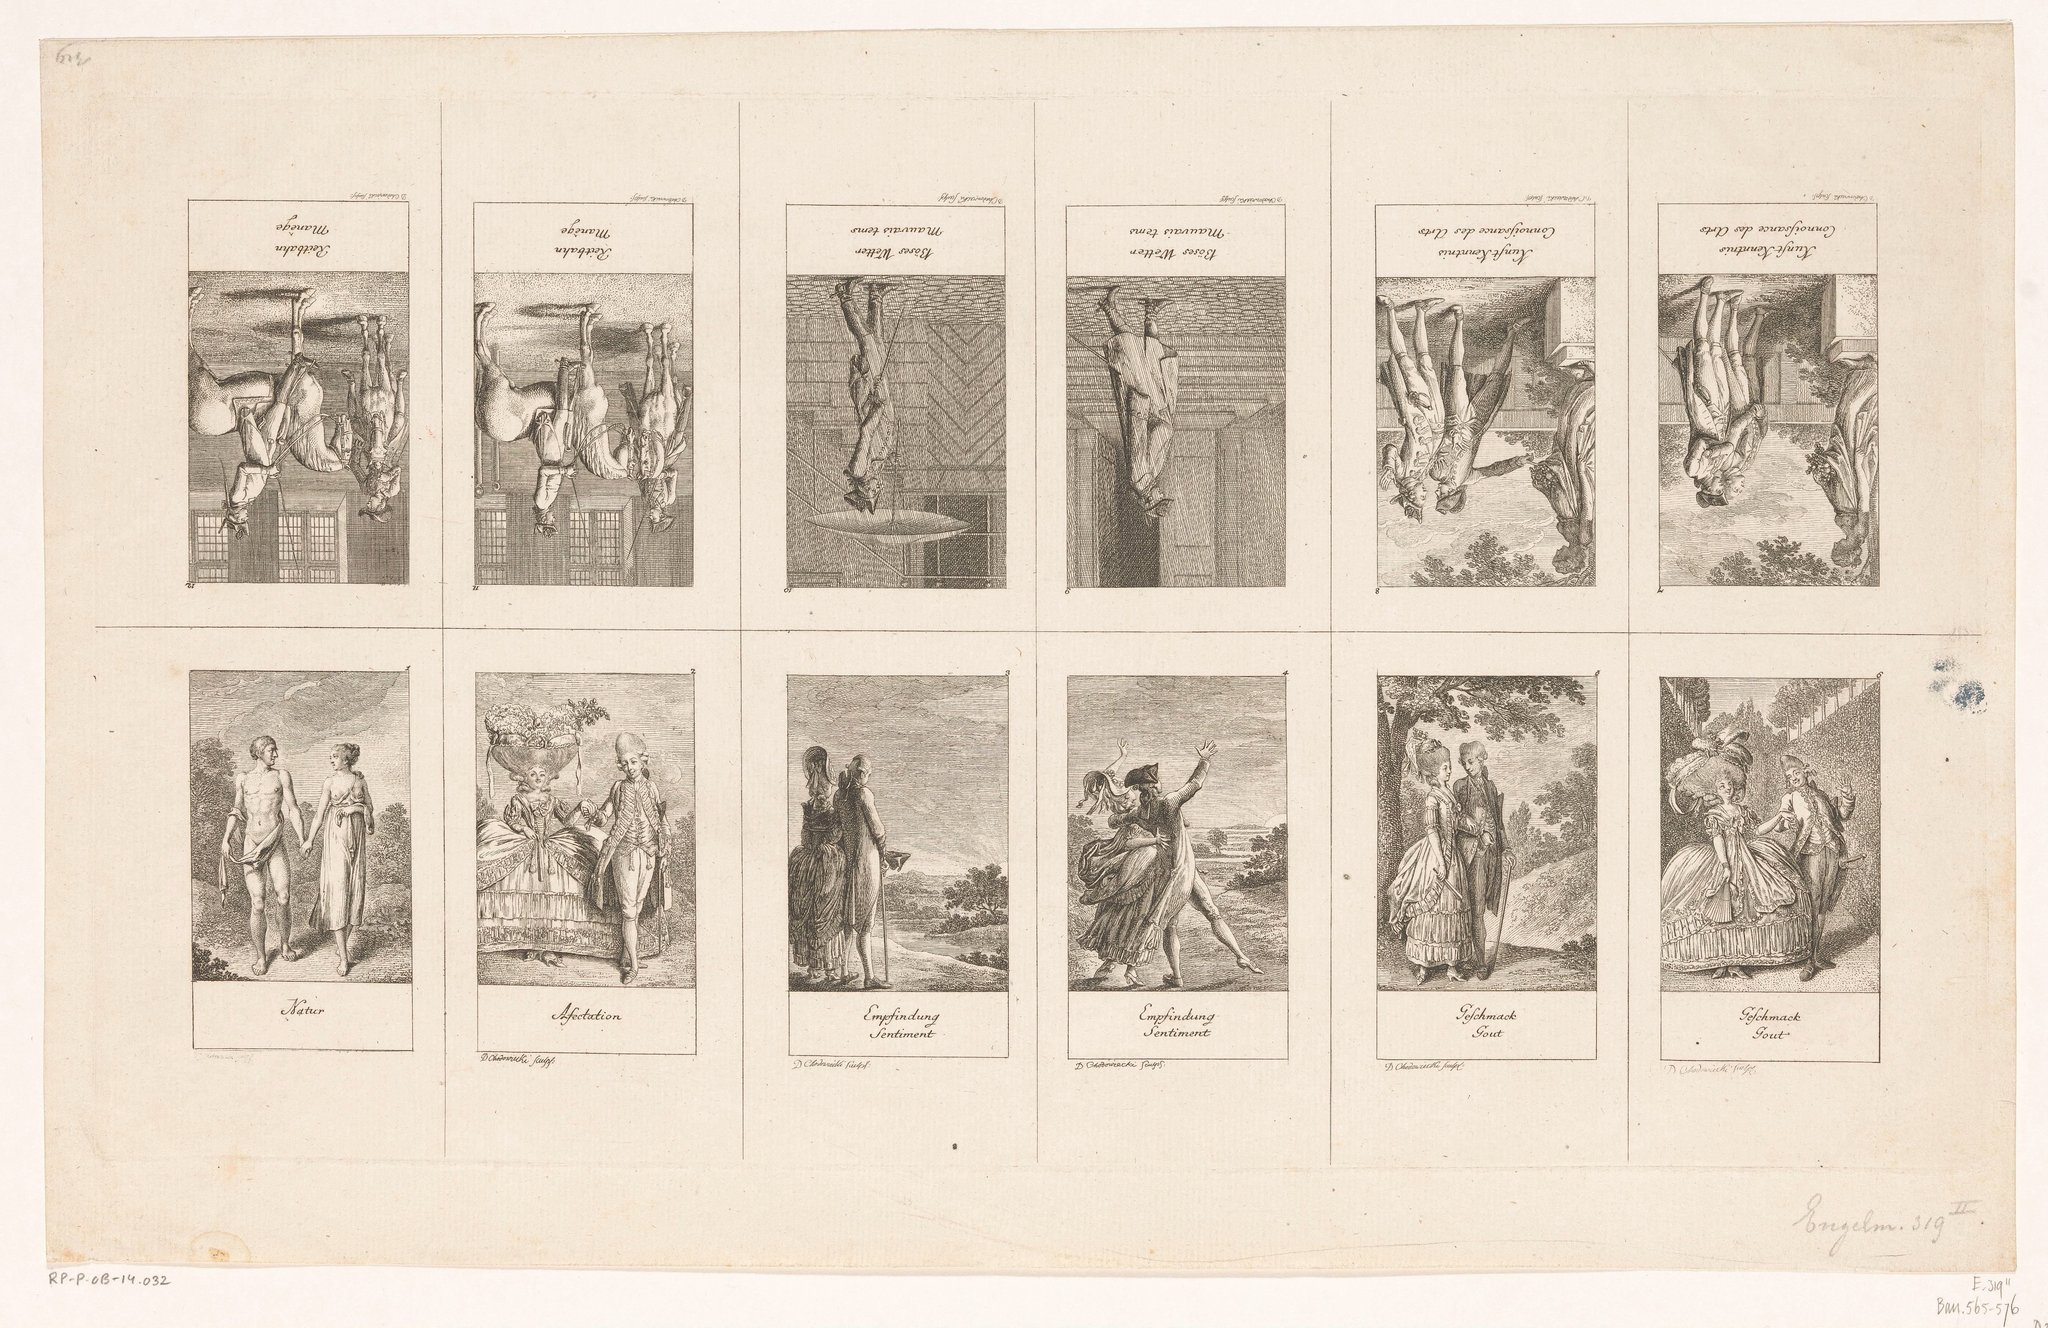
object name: print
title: Twaalf voorbeelden van natuurlijk en geaffecteerd gedrag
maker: daniel nikolaus chodowiecki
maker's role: draughtsman, print maker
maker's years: 1726-1801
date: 1779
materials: paper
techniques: etching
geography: berlin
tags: physicist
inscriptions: collector's mark: Lugt 240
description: Serie van twaalf taferelen die 'Natürliche und affectirte Handlungen des Lebens' (tweede serie) illustreren waarin 'natuurlijk' en 'geaffecteerd' gedrag op karikaturale wijze tegenover elkaar worden gezet. Deze taferelen zijn op een plaat geëtst. Deze serie, voorzien van toelichtingen door Georg Christoph Lichtenberg, is ook gebruikt in: Almanac de Goettingue pour l'année 1780. Göttingen: Johann Christian Dieterich.